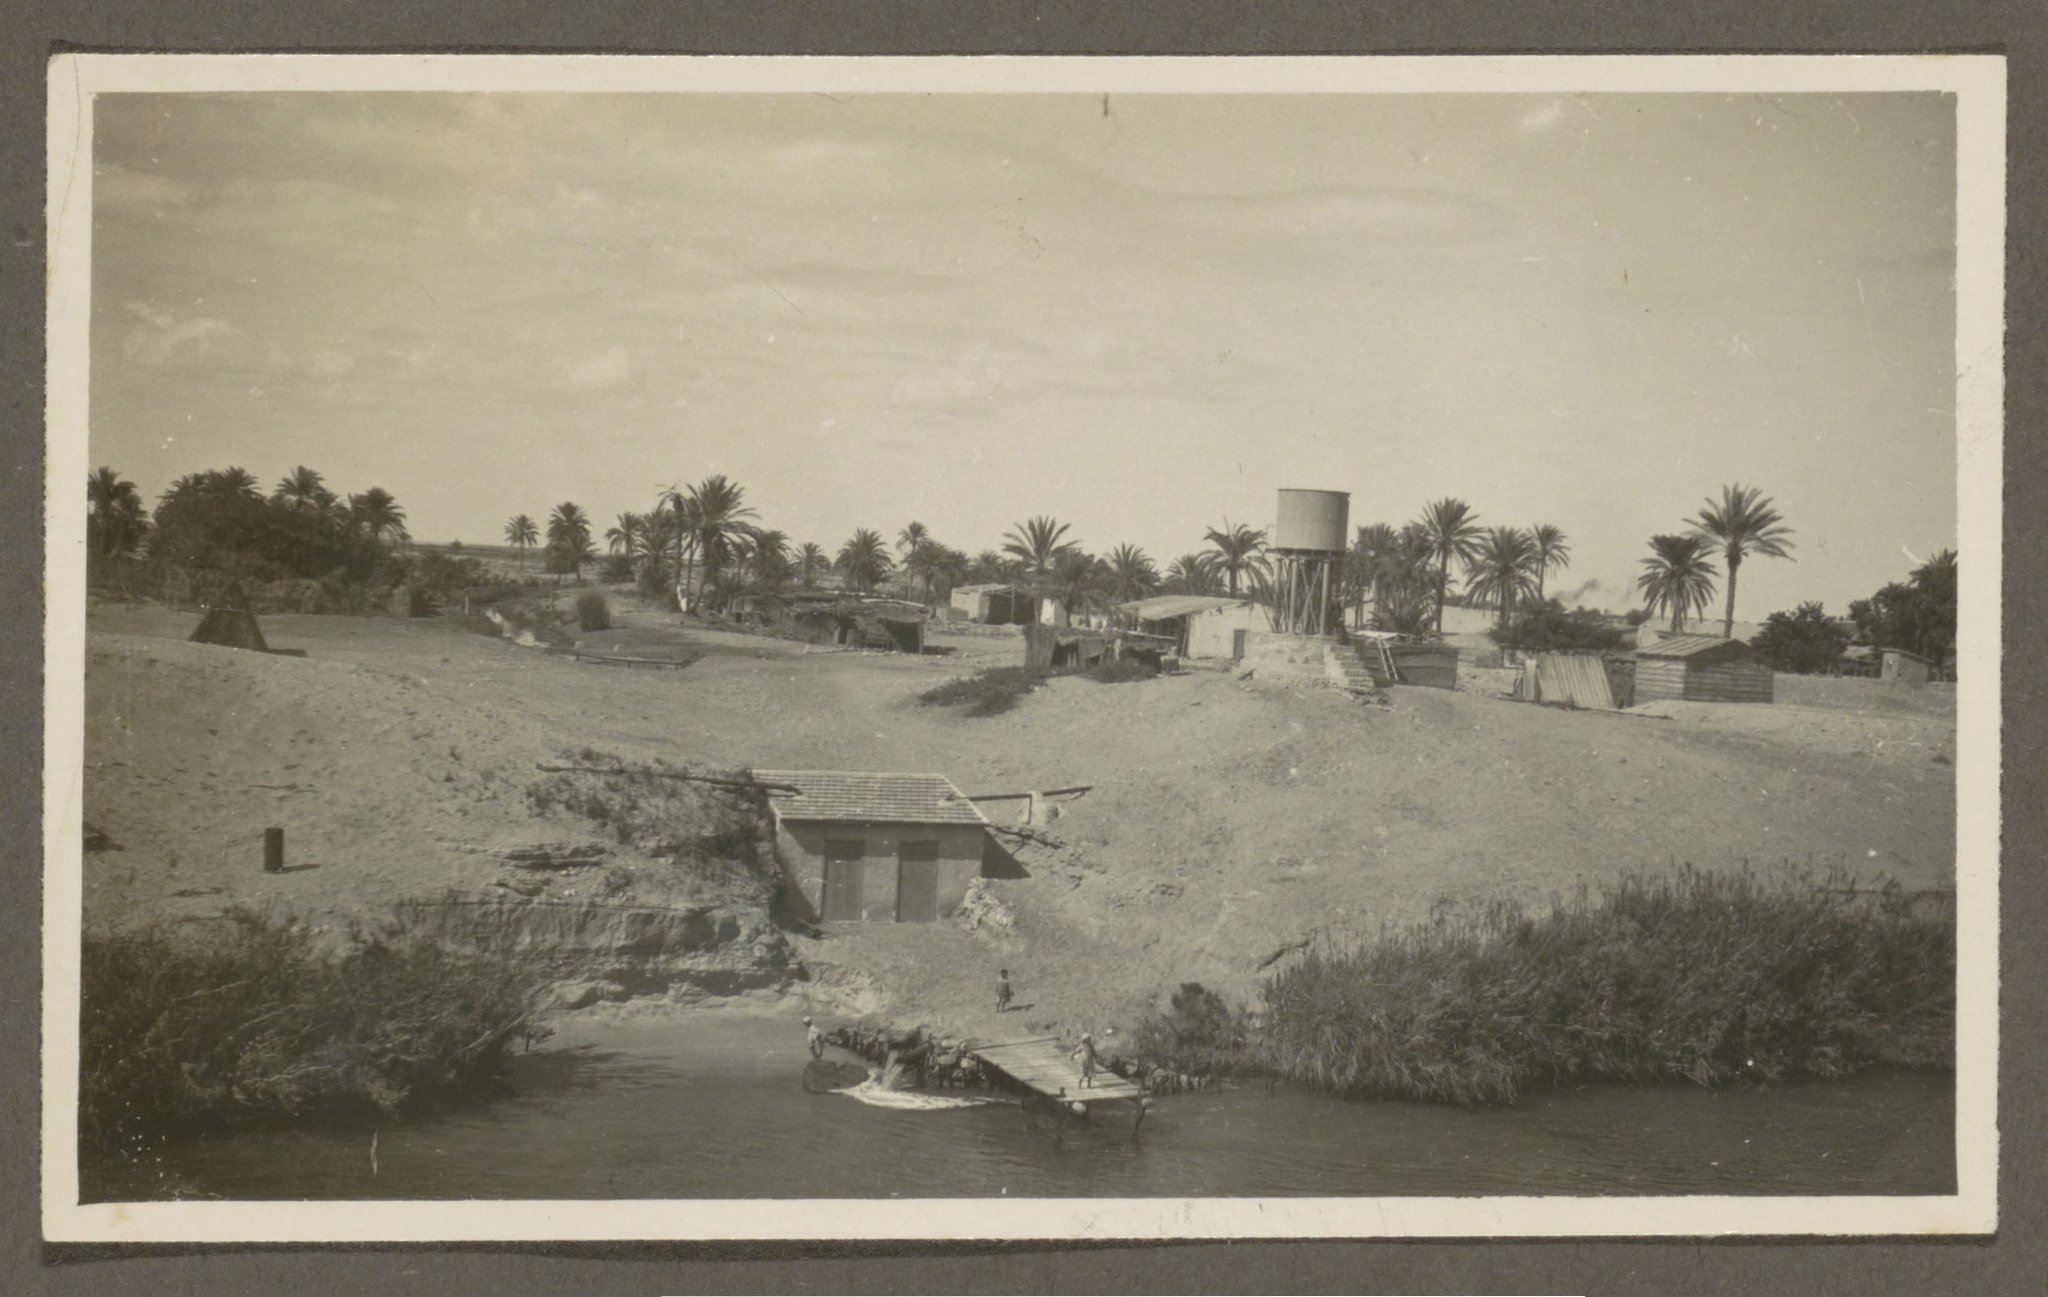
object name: photograph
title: Zicht op een dorp met een waterbassin en palmen aan een oever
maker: Anonymous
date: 1920-1930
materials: photographic support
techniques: gelatin silver print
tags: prospect of village, silhouette of village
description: Onderdeel van familiealbum Nederlands-Indië.